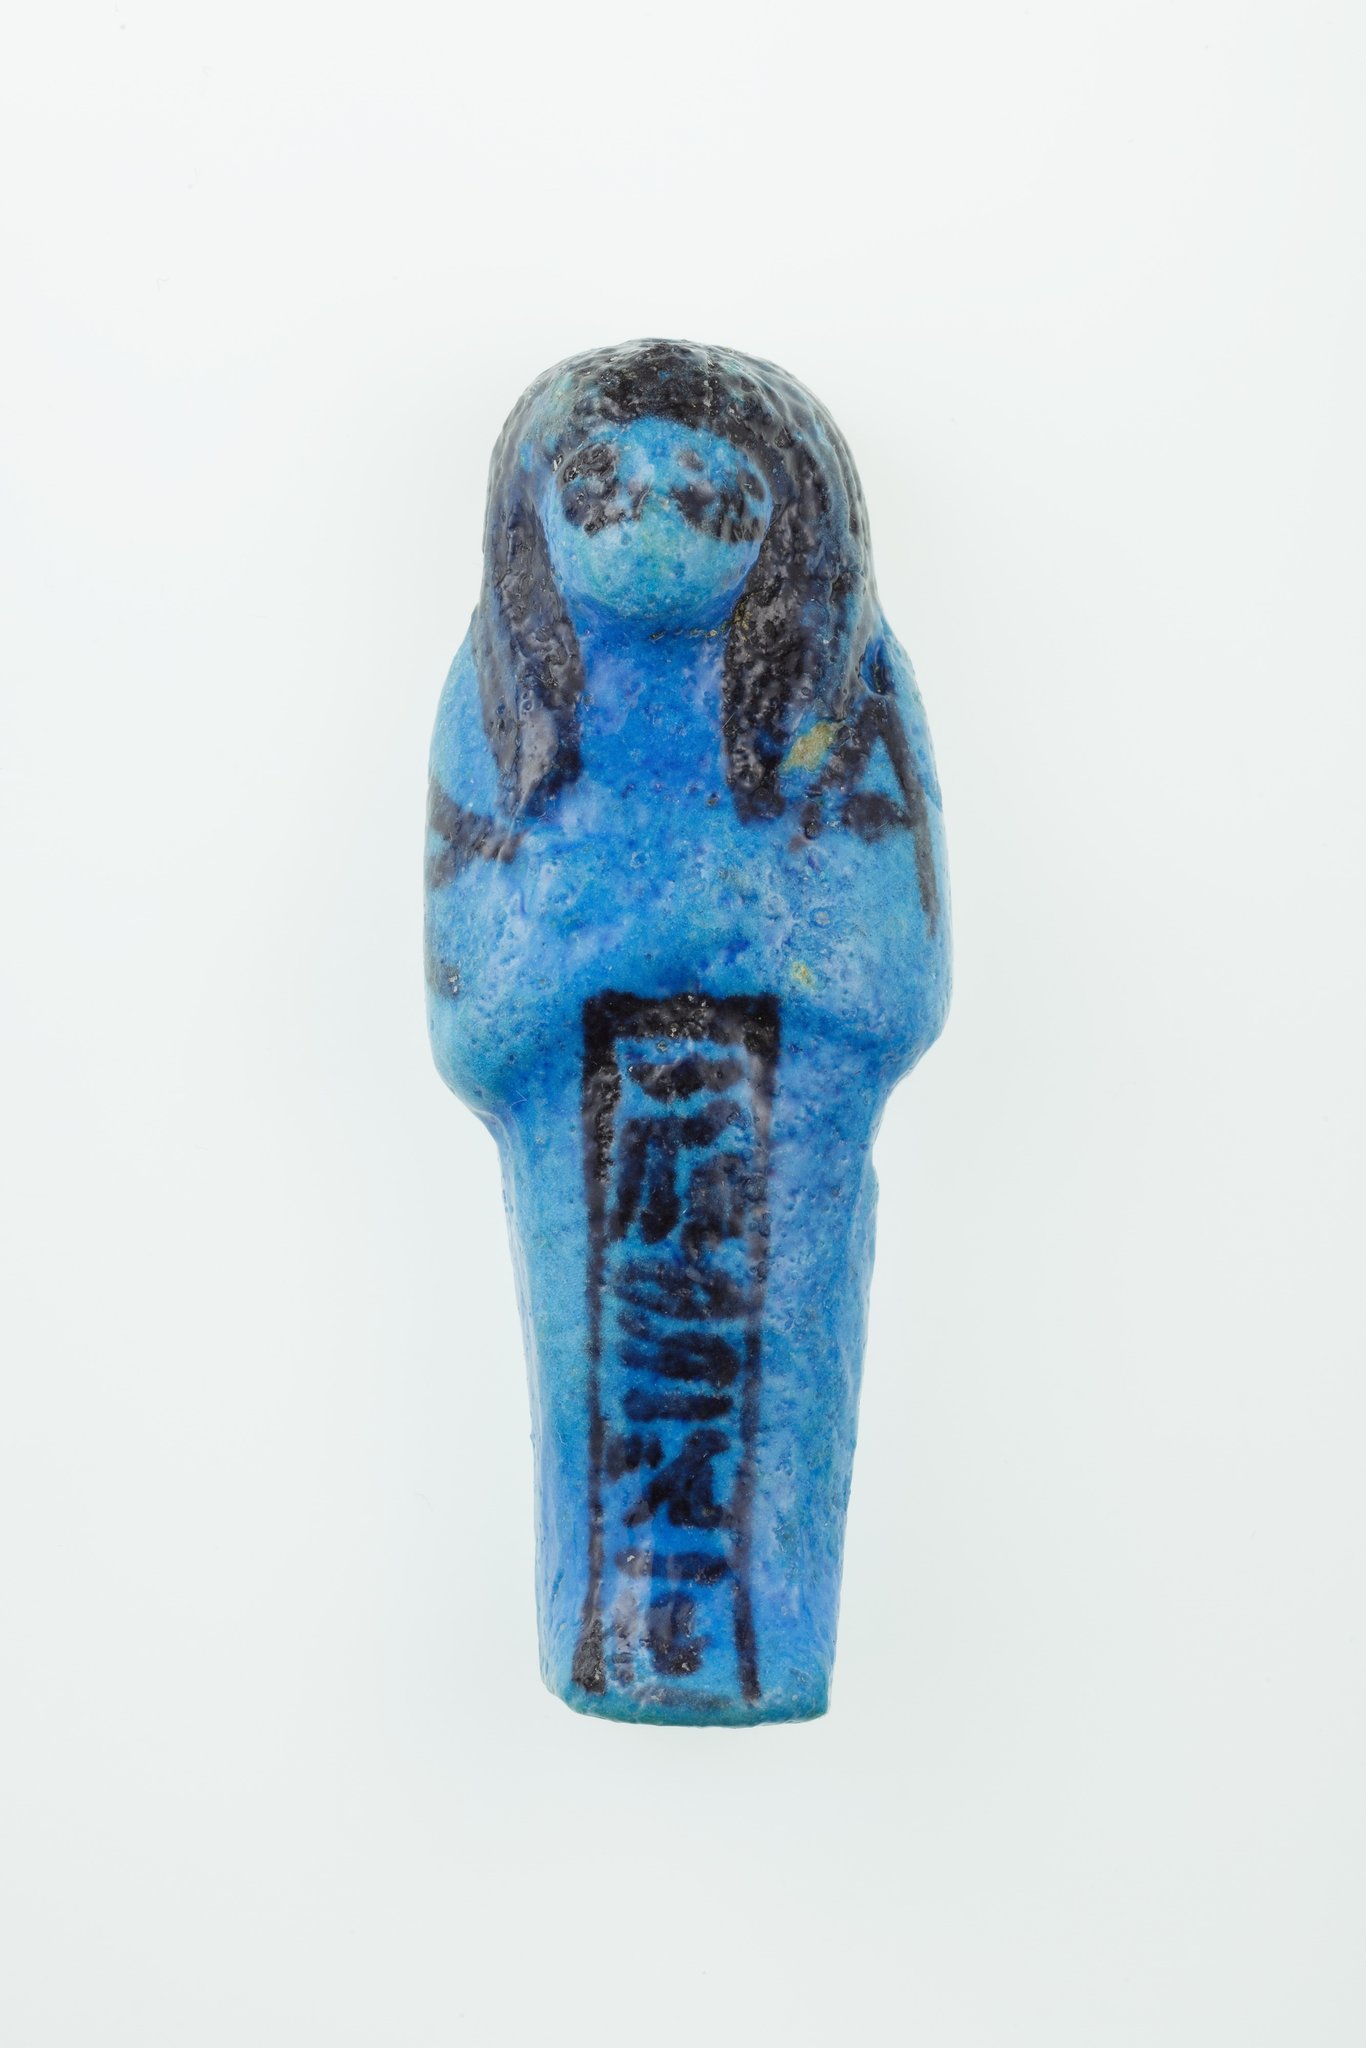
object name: shabti, worker, nauny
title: Worker Shabti of Nauny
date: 1050 BCE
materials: faience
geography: egypt